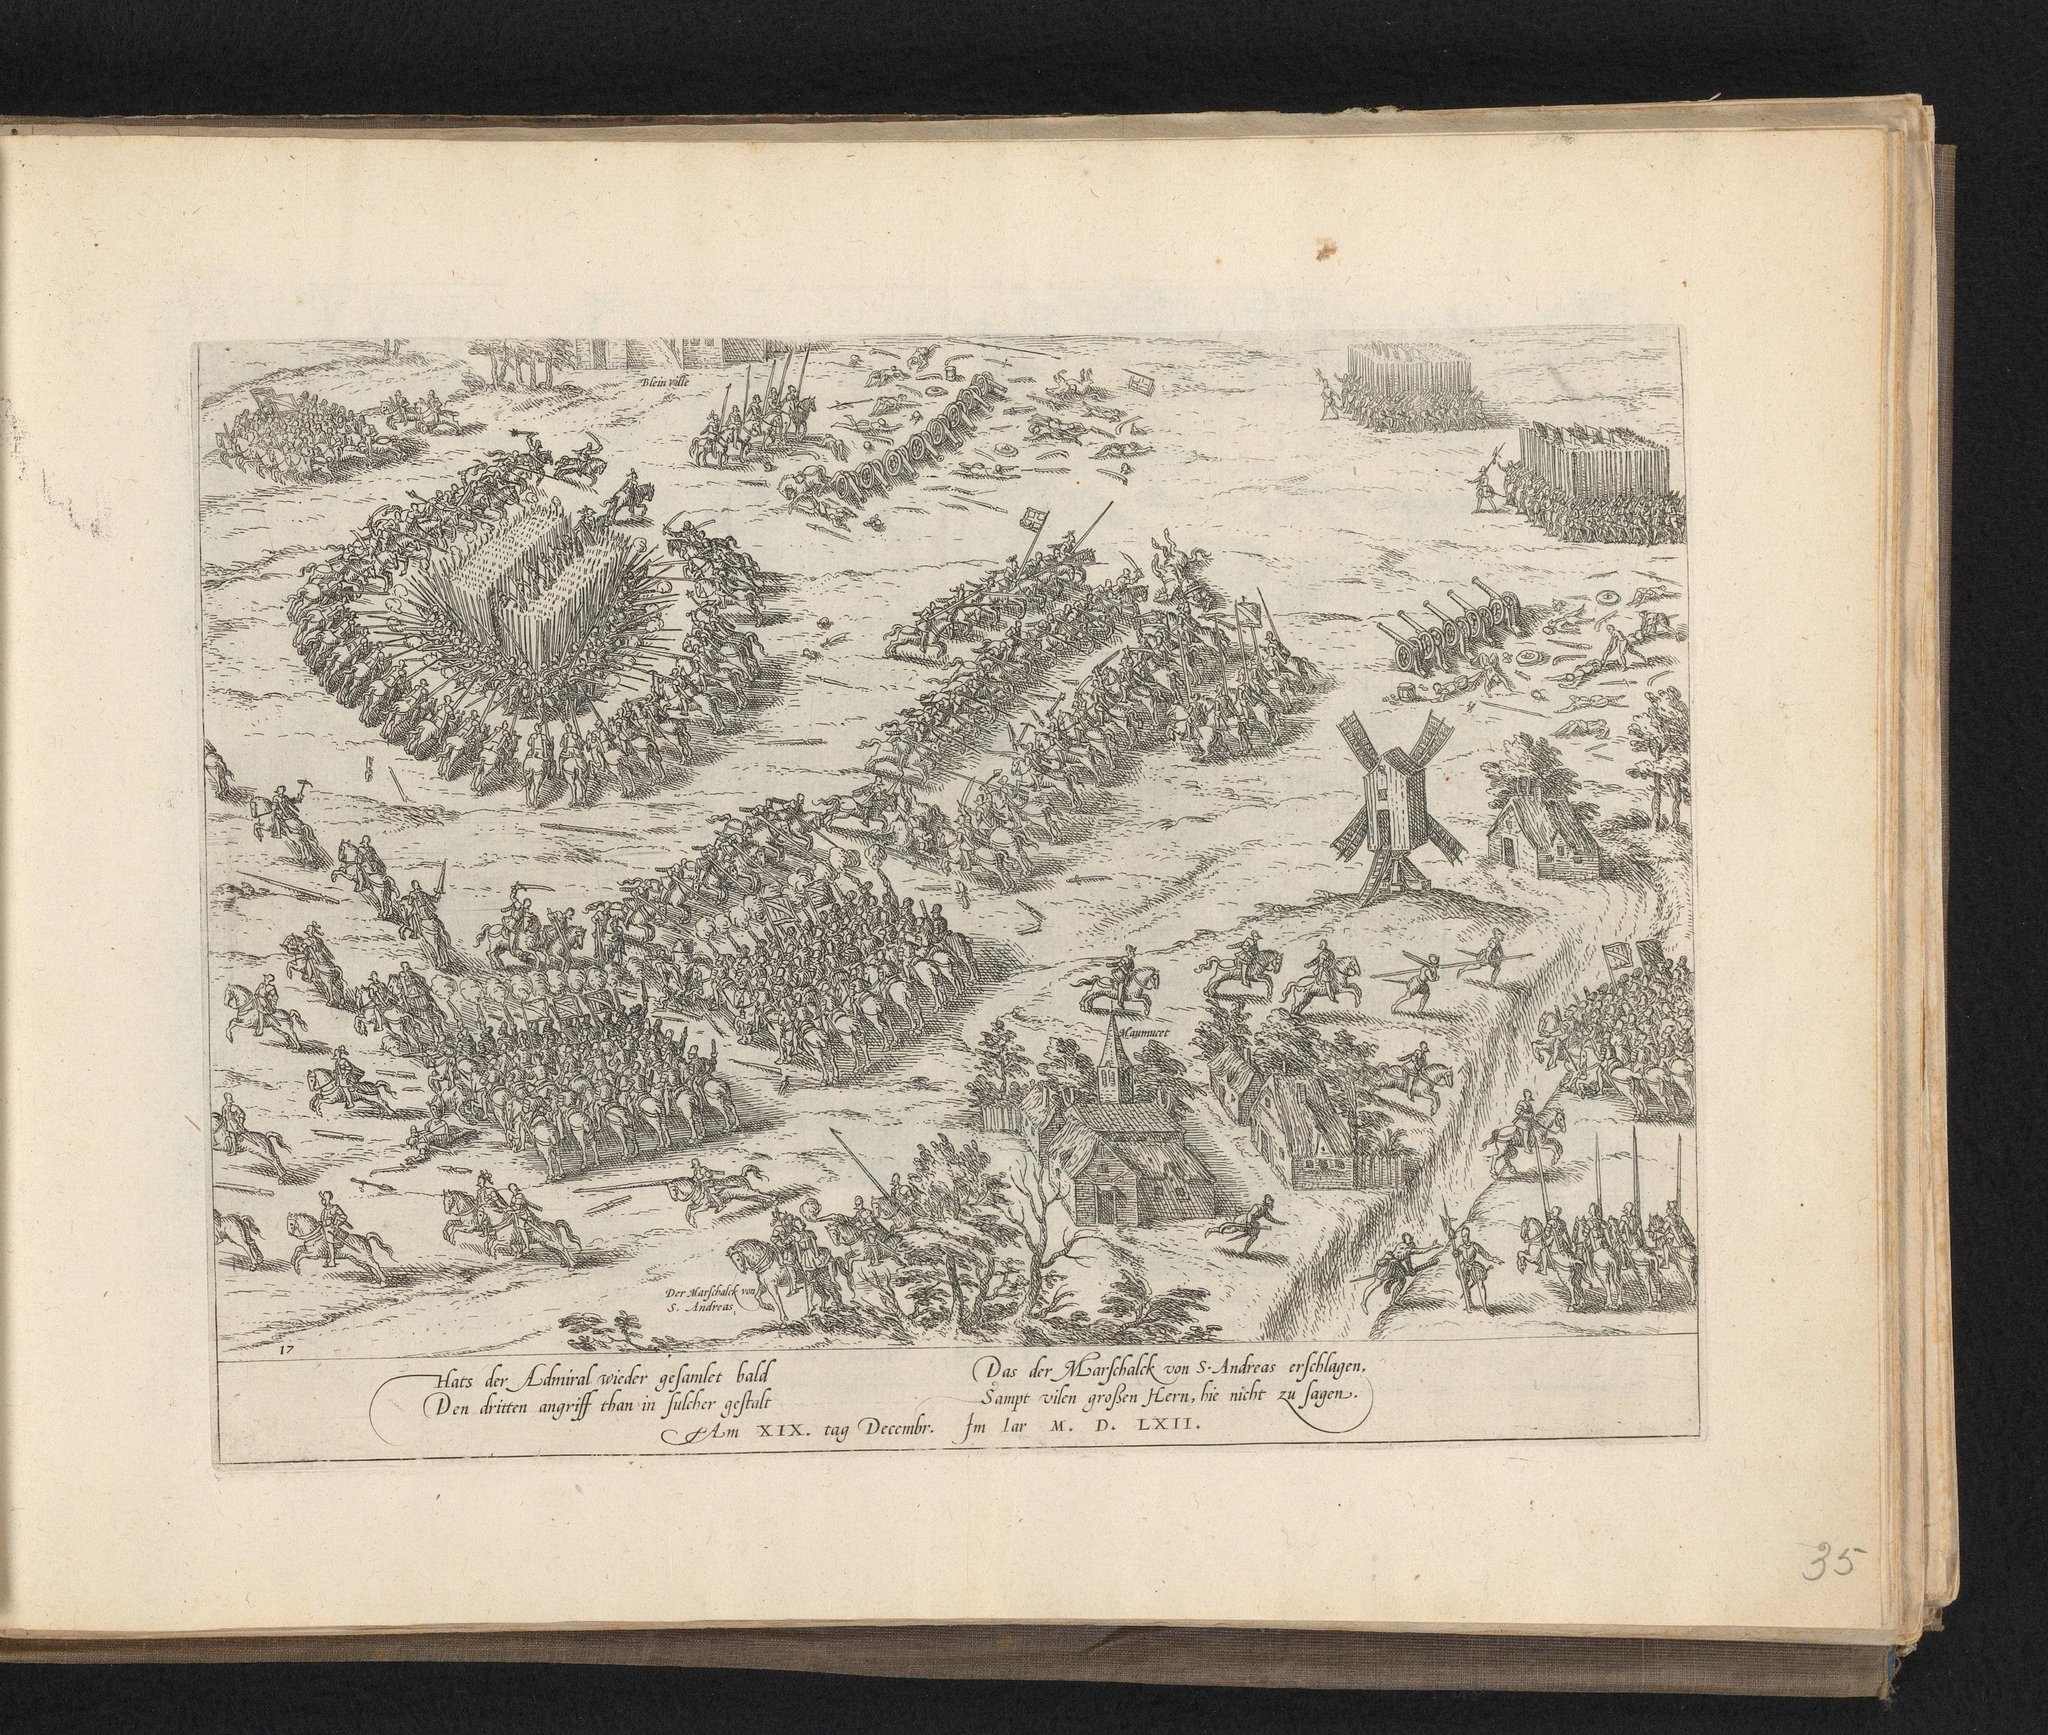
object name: album leaf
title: Serie 3: Franse Godsdienstoorlogen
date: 1562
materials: paper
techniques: etching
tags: battle, fighting in general, militant proselytizing: religious war, crusade, etc., the roman catholic church vs. protestantism; (reformation and counter reformation)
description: Prent gebruikt in: Aitsinger, Michael. De Leone Belgico (...). Keulen: s.n., 1588.